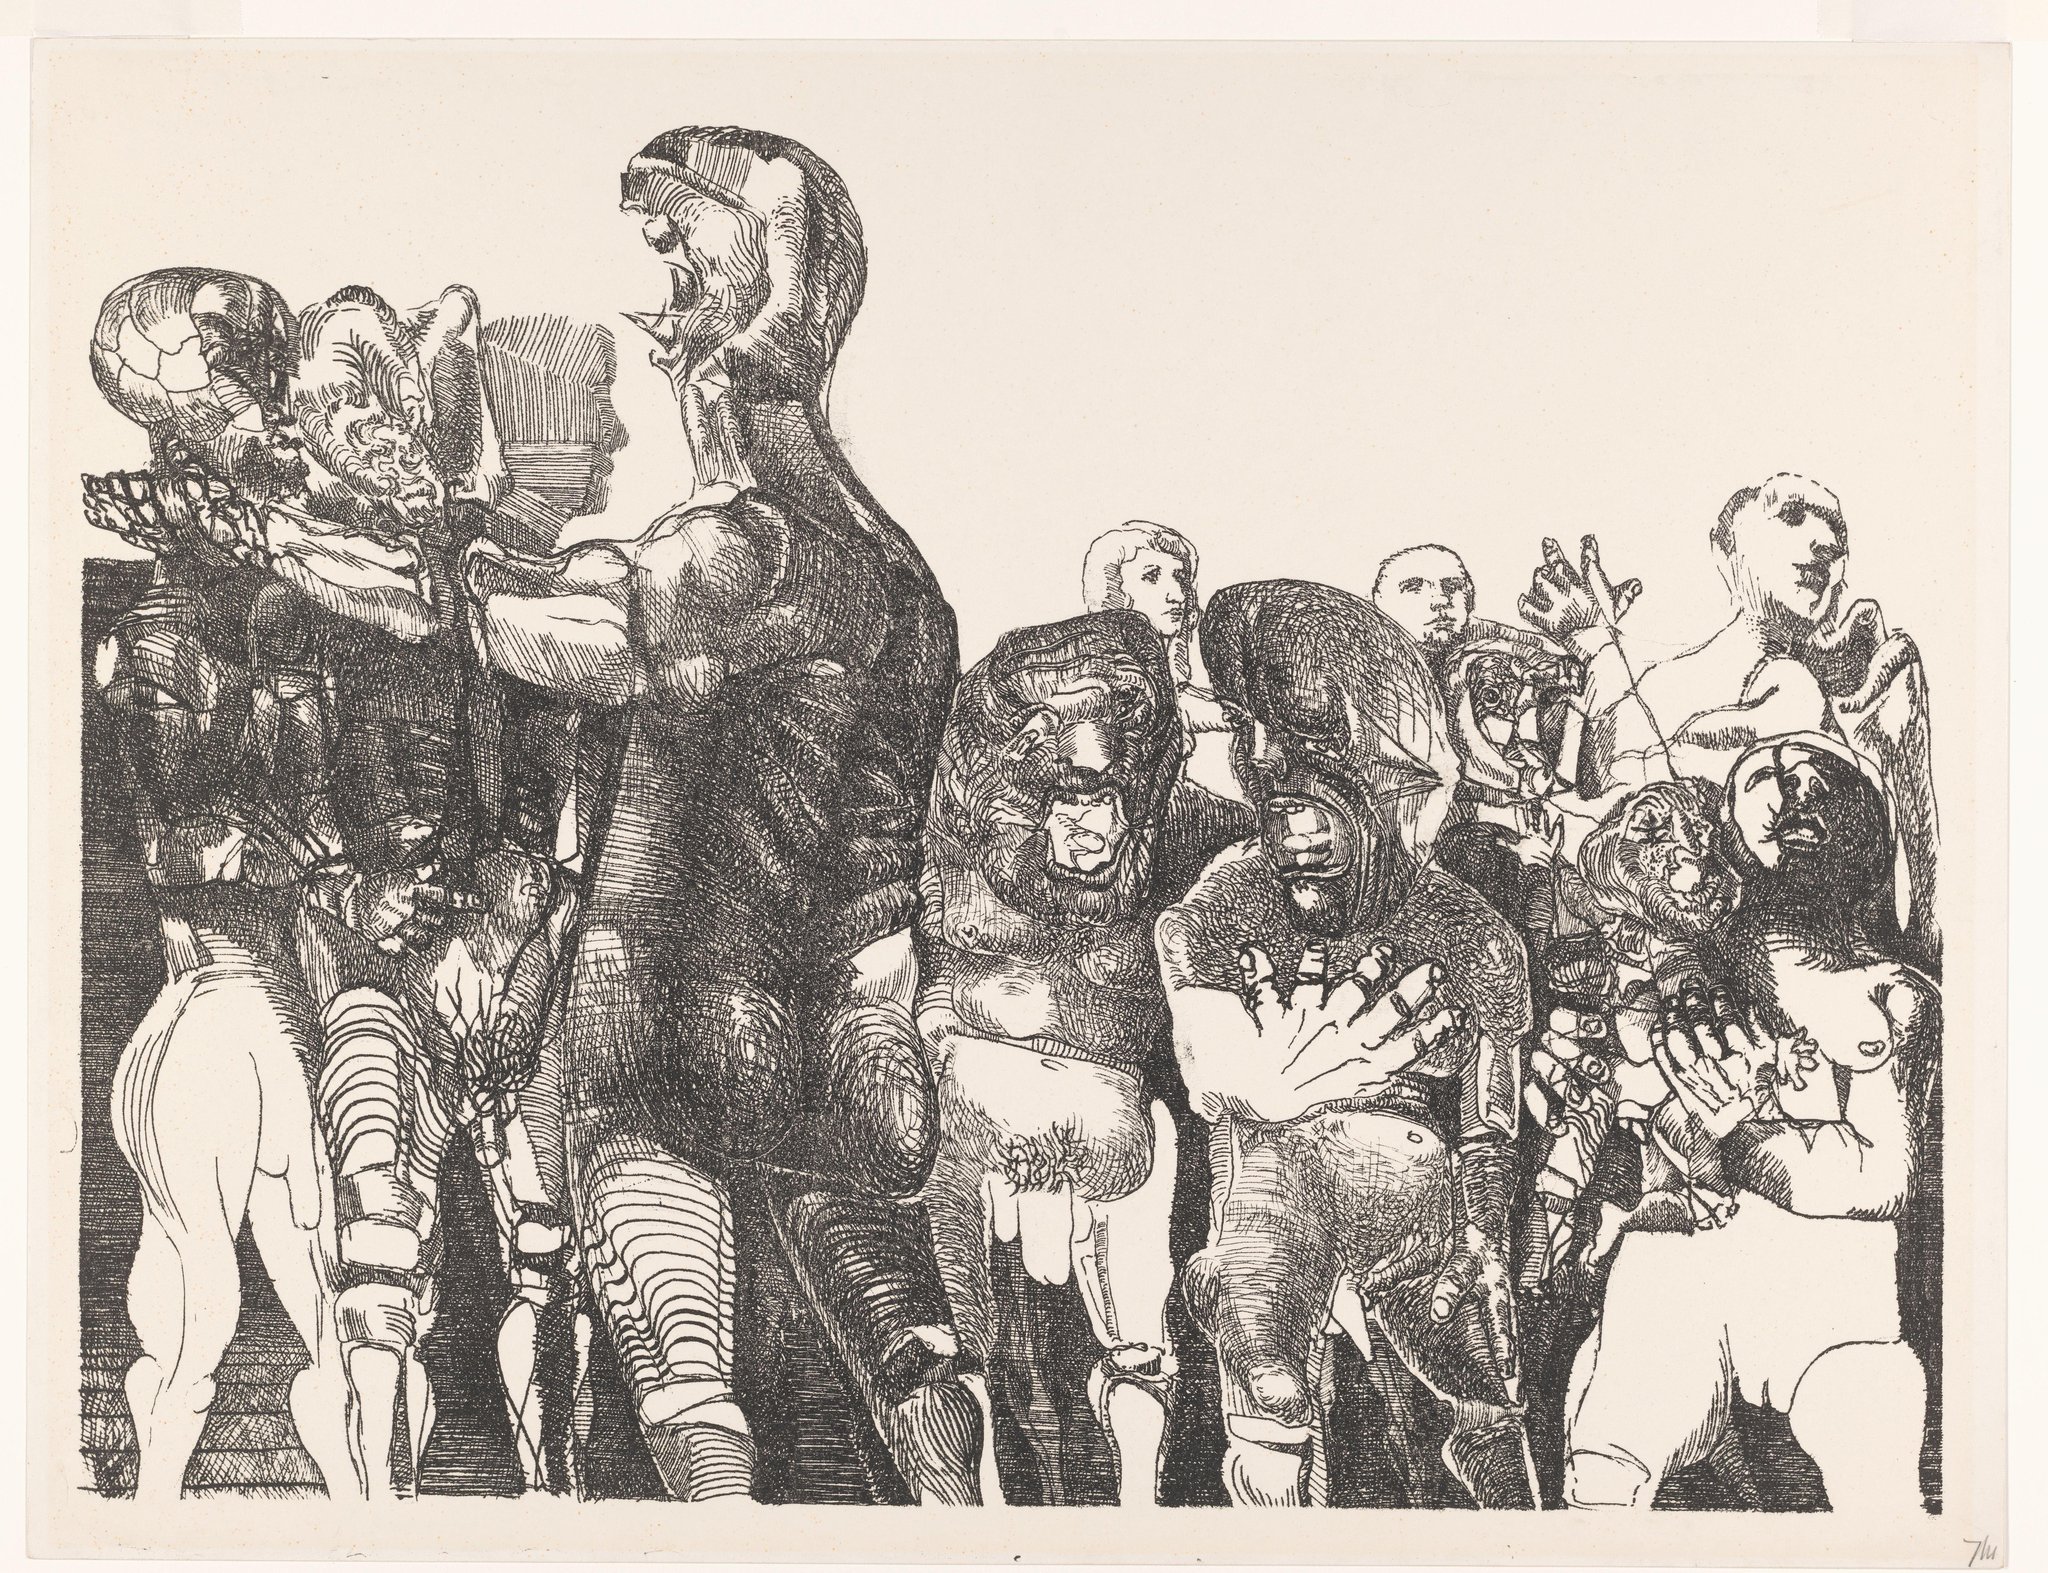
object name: print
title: Menigte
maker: aat verhoog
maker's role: print maker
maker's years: 1933-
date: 1962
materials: paper, ink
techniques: lithograph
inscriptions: signature: ‘Aat Verhoog’, title: ‘'Menigte'’, edition: ‘7/14’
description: Verschillende antropomorfe figuren, van onderaf gezien, met links van het midden een naakte wijzende man op de rug gezien.